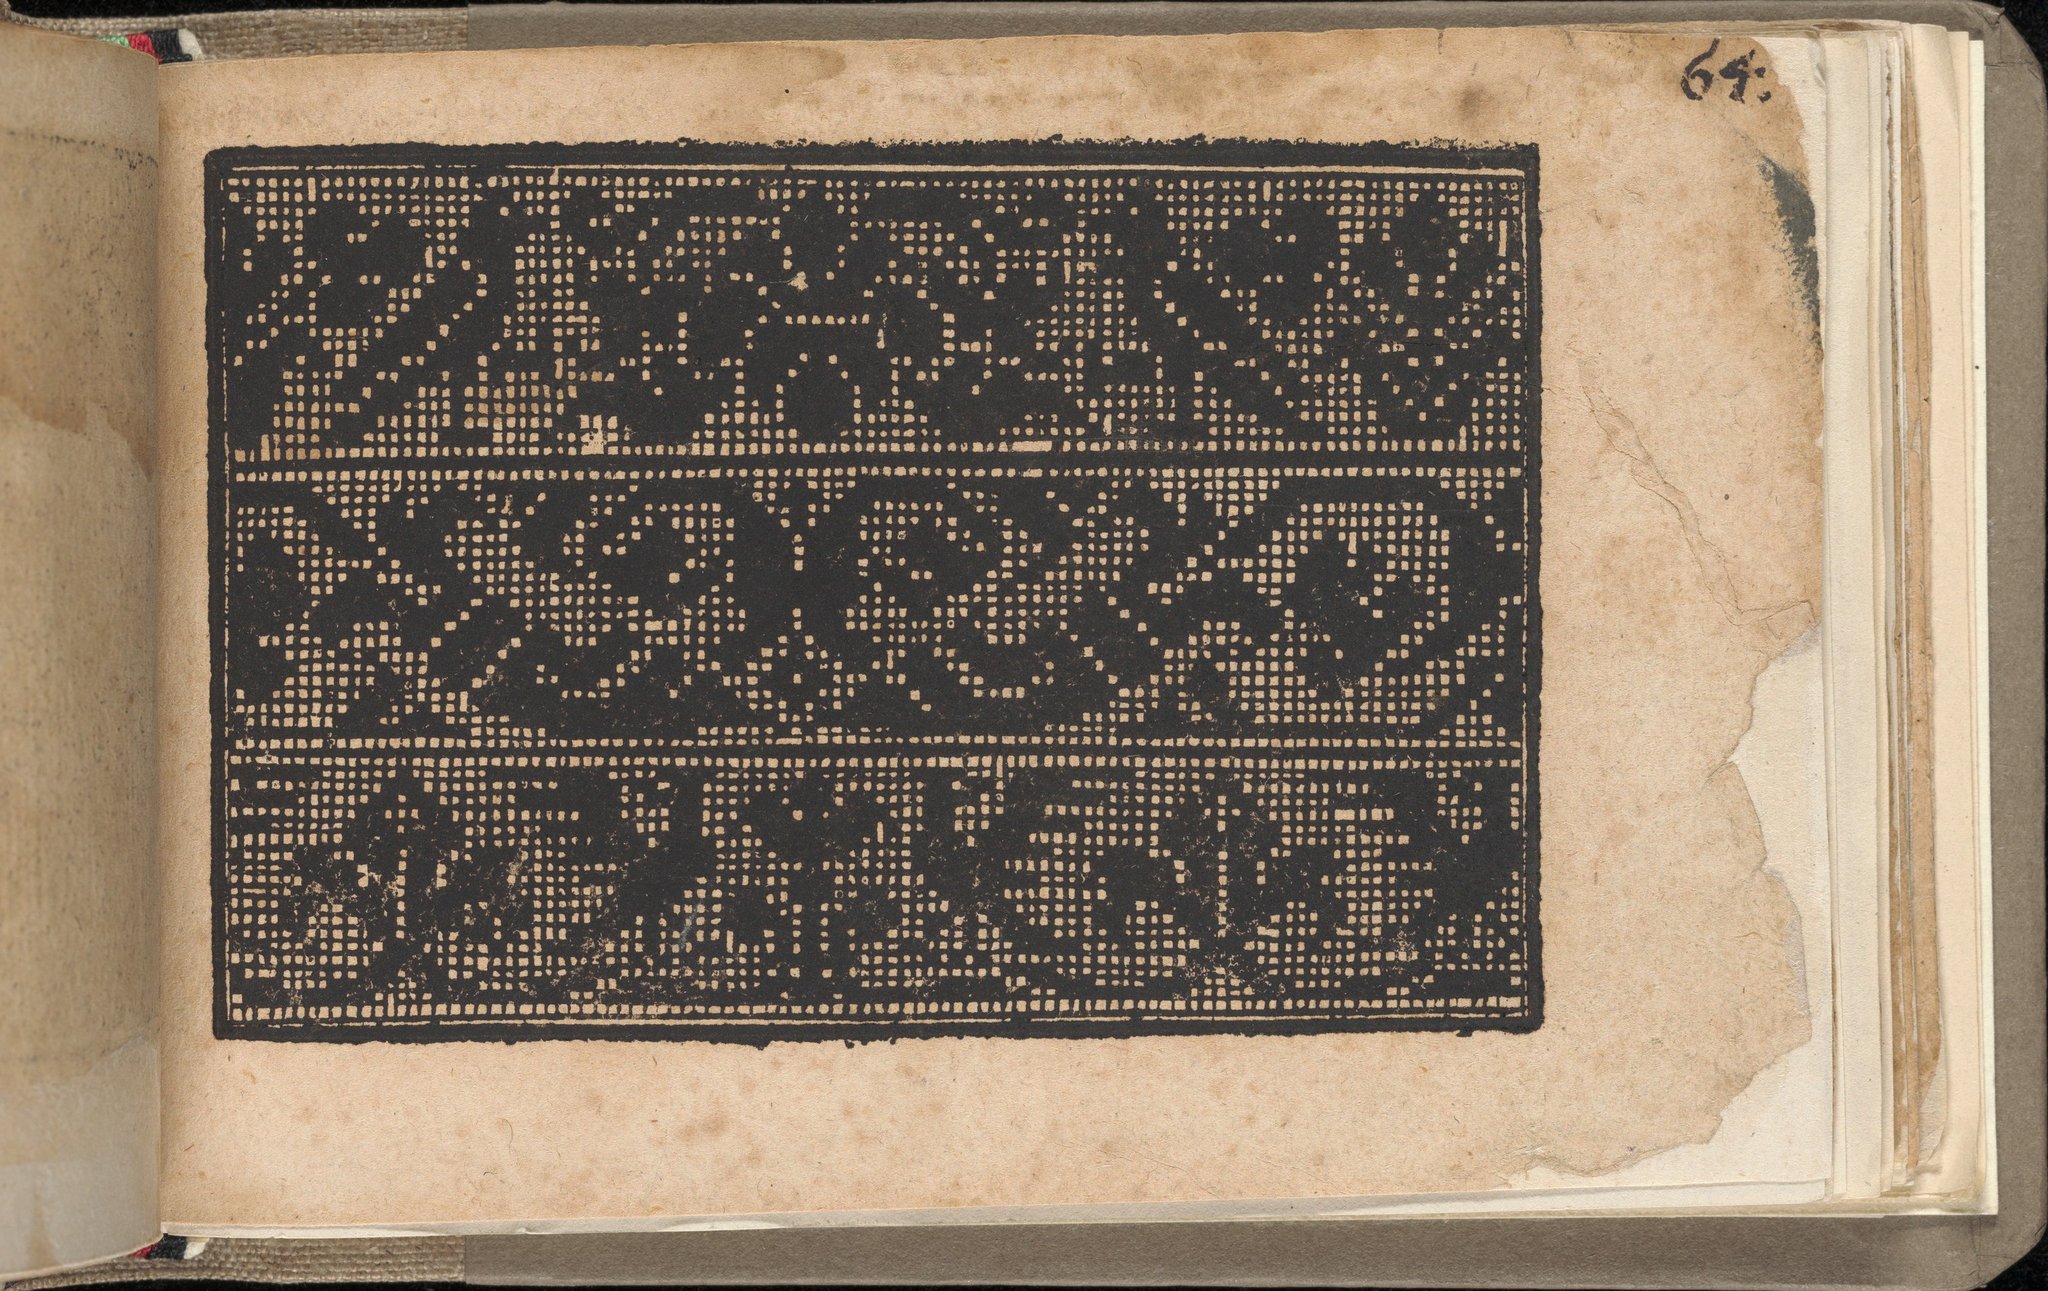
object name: book print ornament architecture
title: Schön newes Modelbuch (Page 64r)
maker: sigismundus latomus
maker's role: publisher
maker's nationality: german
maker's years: 1599-1632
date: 1608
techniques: woodcut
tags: ornament